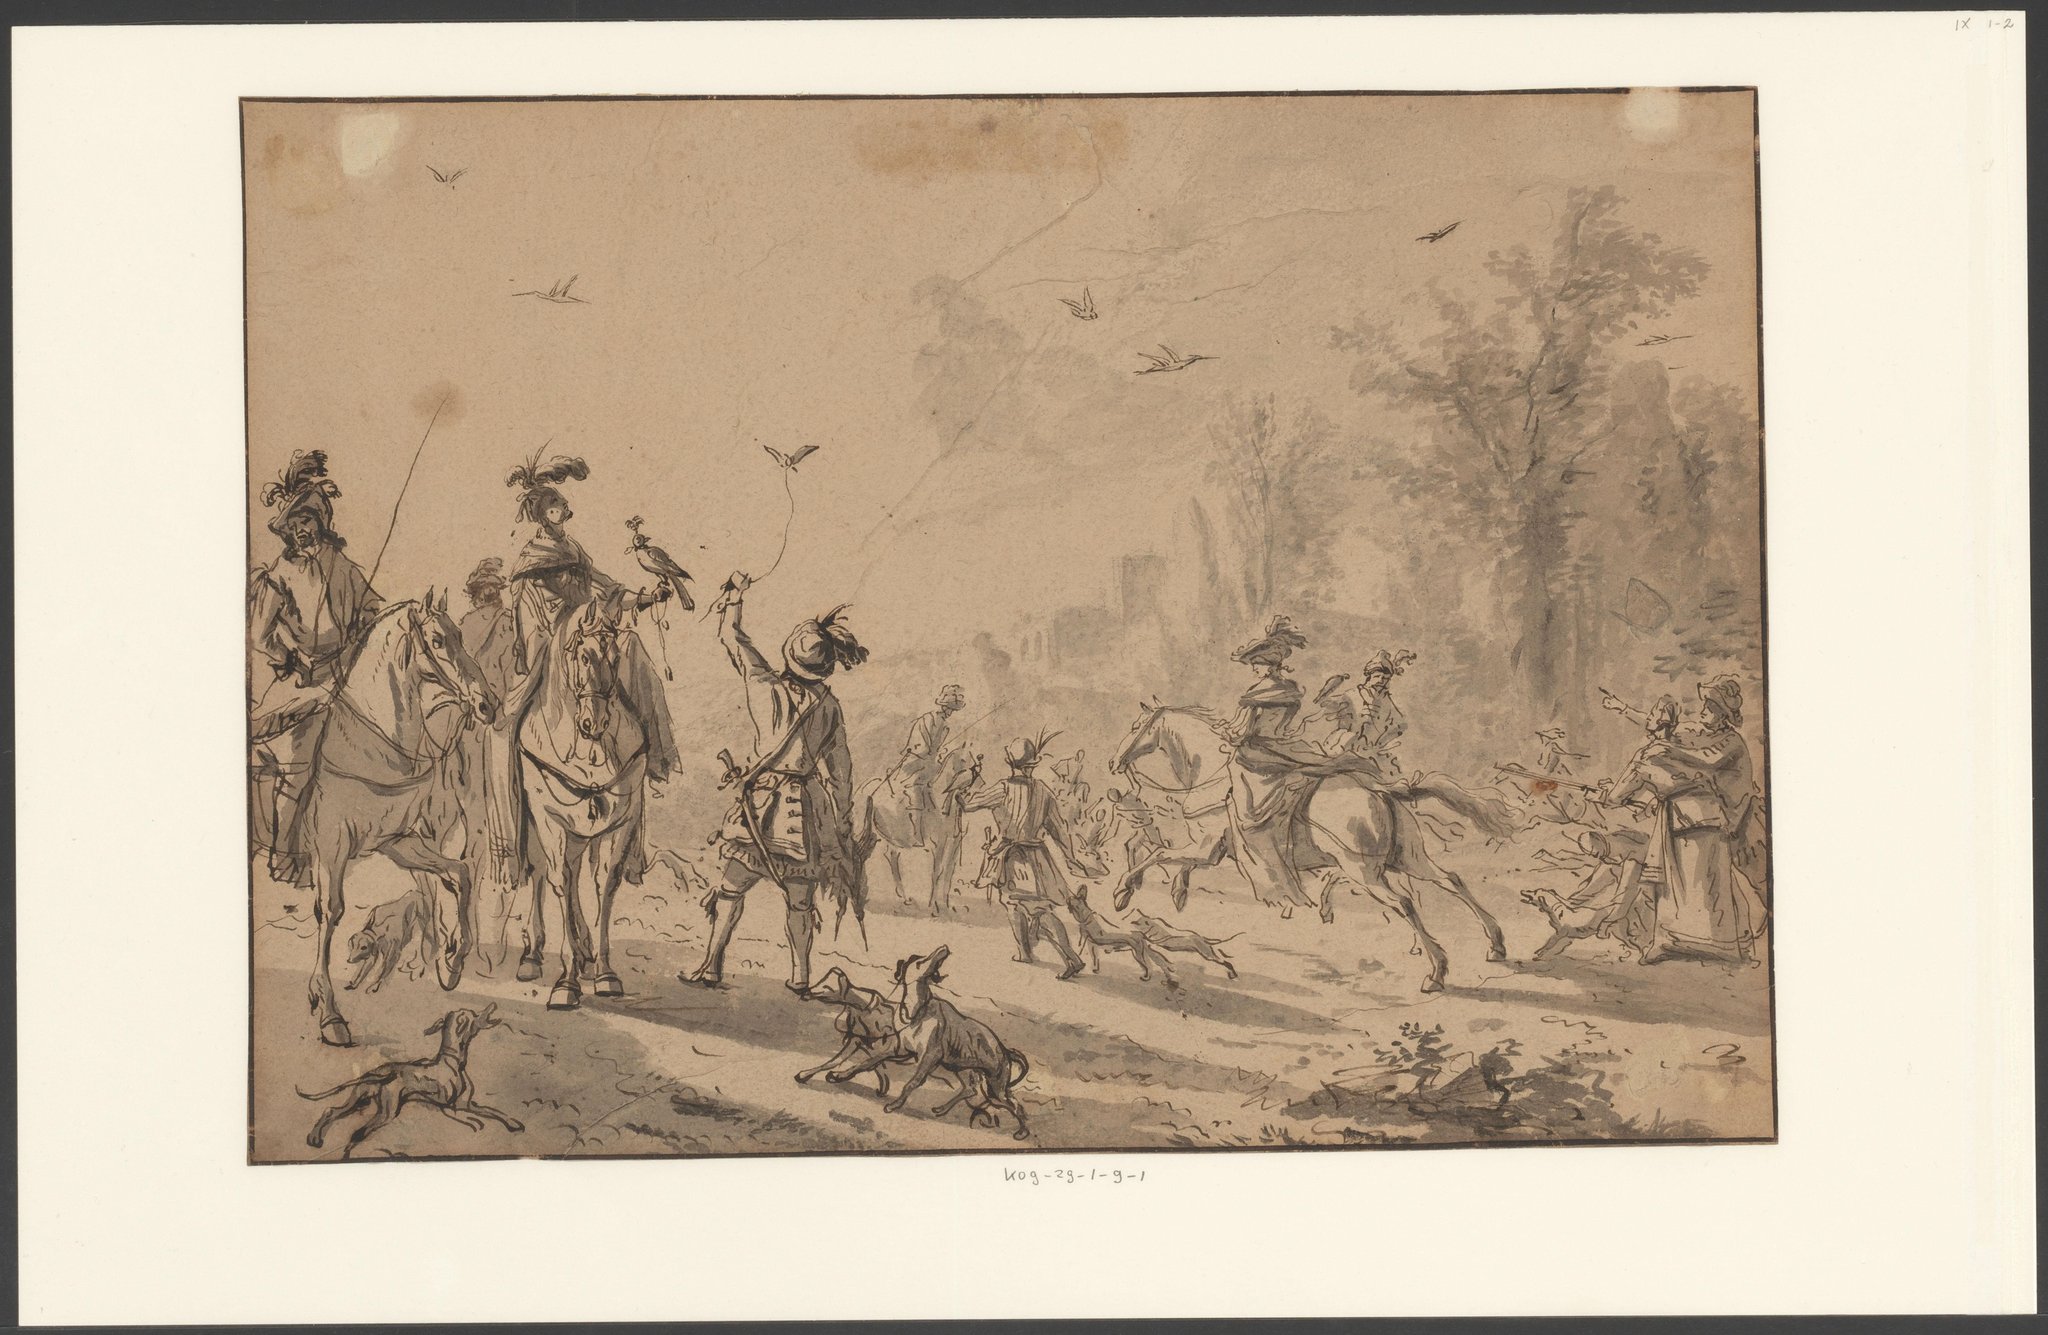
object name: drawing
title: Valkenjacht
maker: dirk maas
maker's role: draughtsman, print maker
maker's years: 1659-1717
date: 1669-1717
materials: ink, paper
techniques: brush, pen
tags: predatory birds: falcon, game, hunted animals, bird hunting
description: Mannen en vrouwen, te paard en te voet tijdens de valkenjacht. Onderwerpsrubrieken binnen de Atlas Zeden en Gewoonten: Handel, nijverheid en verkeer, jacht.